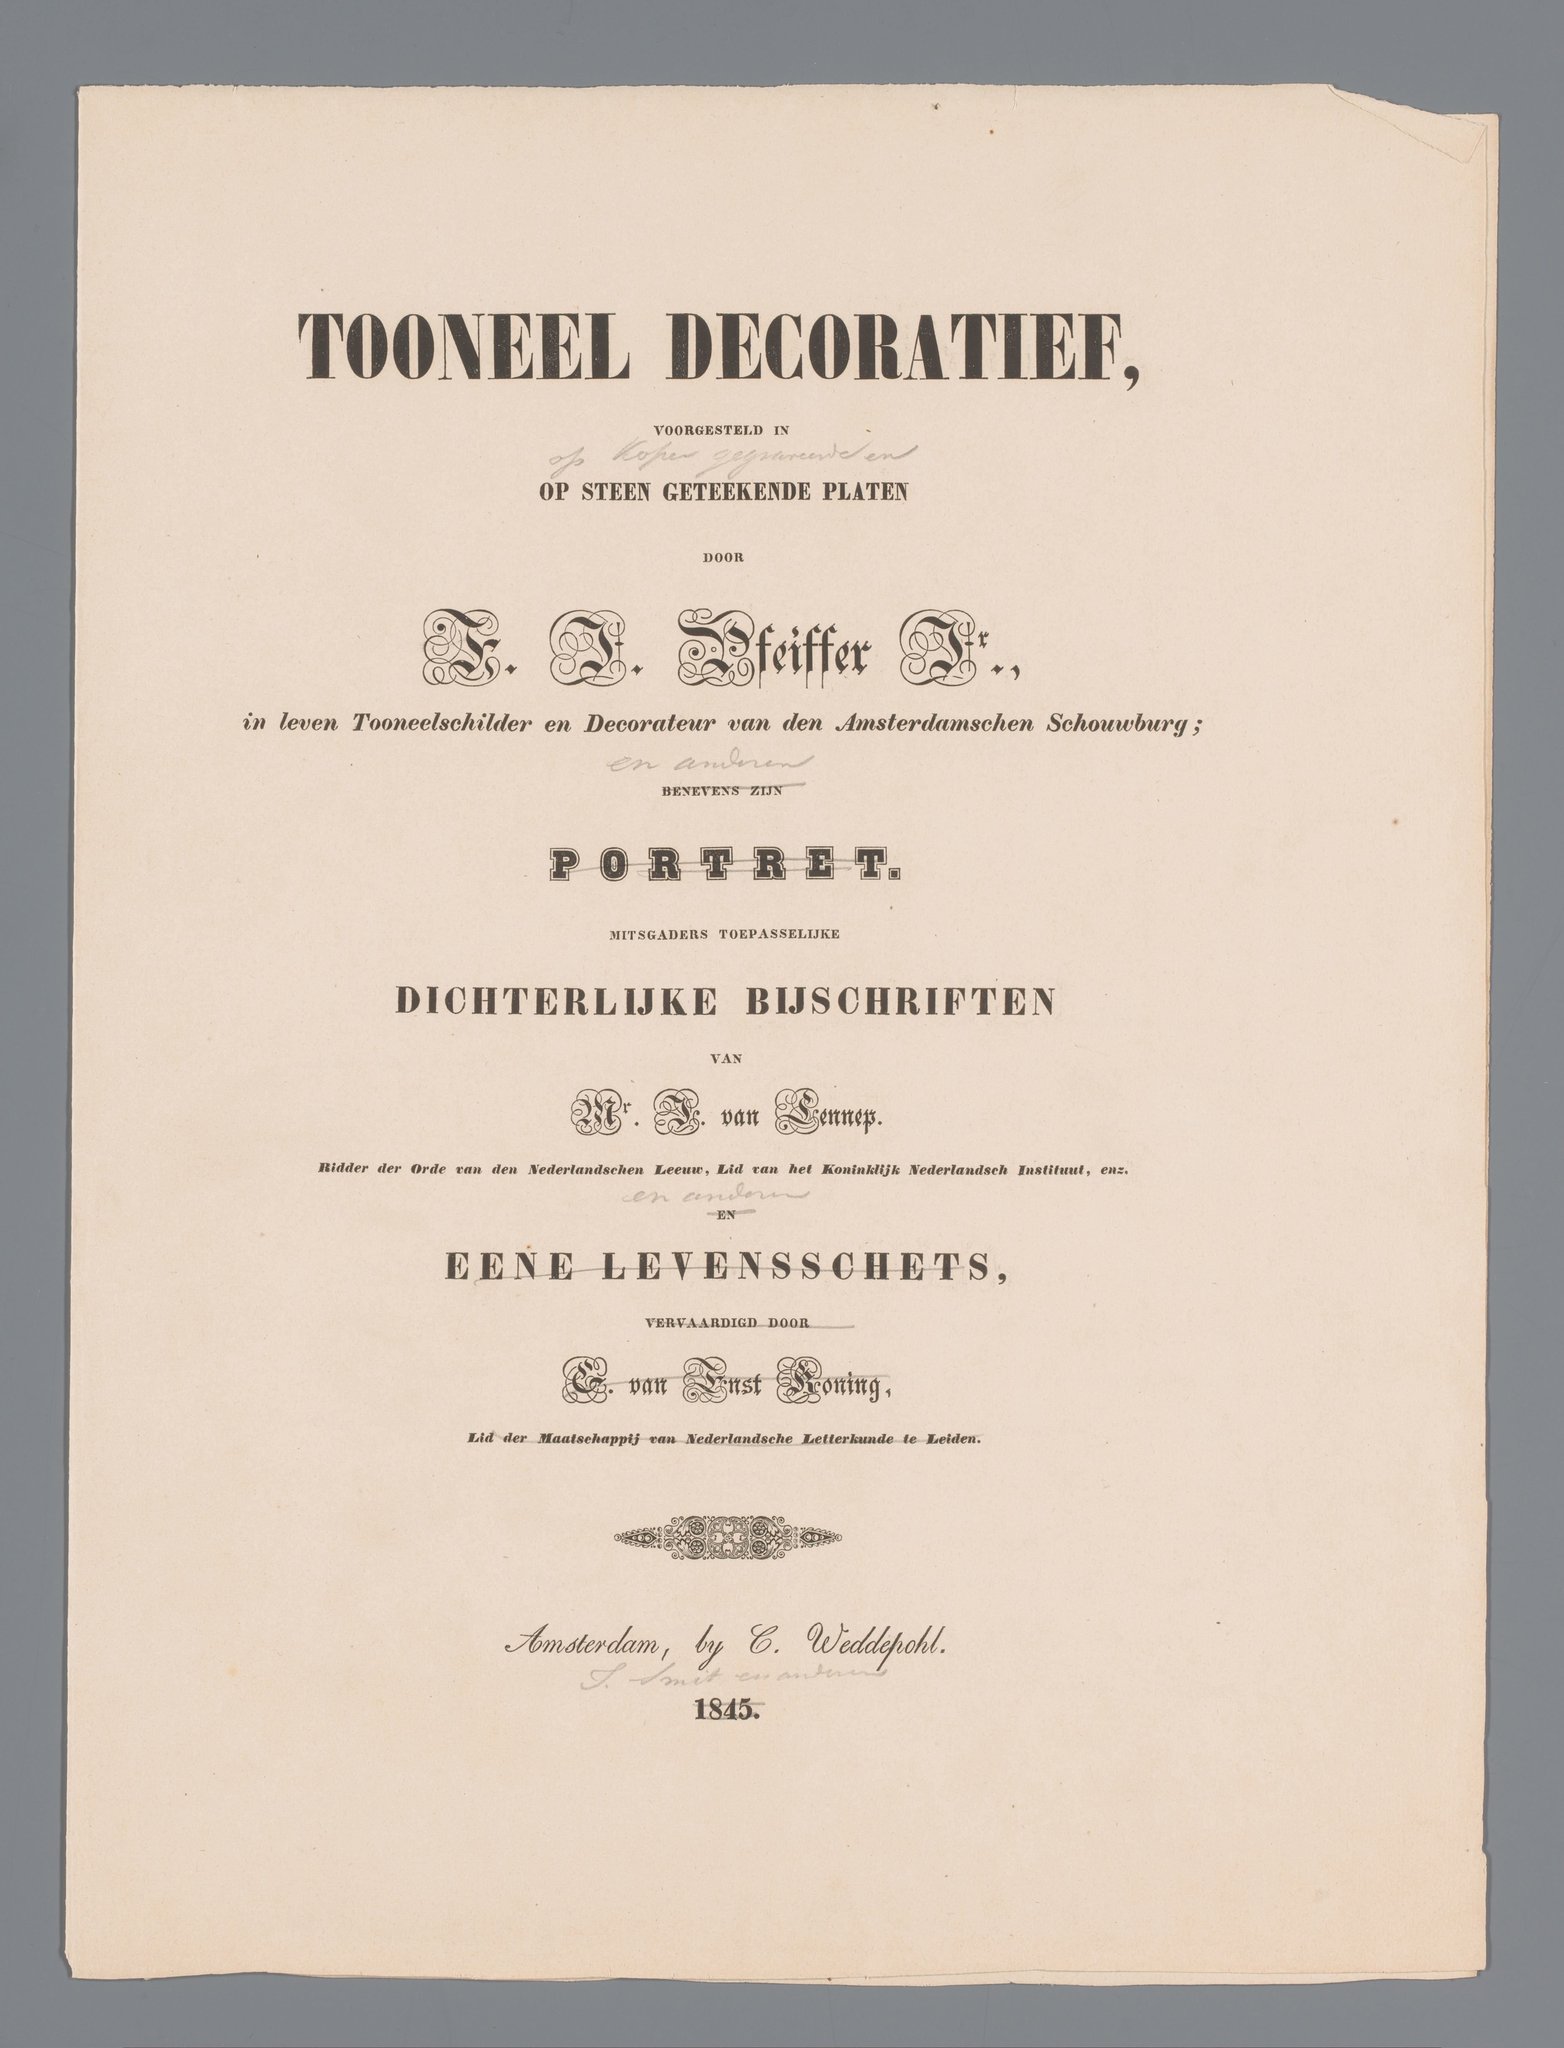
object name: print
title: Titelpagina voor: J. van Lennep en G. van Ernst Koning, Tooneel decoratief, 1845.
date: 1845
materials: paper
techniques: letterpress printing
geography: amsterdam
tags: group of actors, troupe; actors on the stage, title-page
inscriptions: date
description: Gedrukte tekst deels met potlood doorgestreept en aangepast. Prent uit: Prent uit: Lennep, J. van; Ernst Koning, G. van. Tooneel decoratief. Amsterdam: Weddepohl, C., 1845.